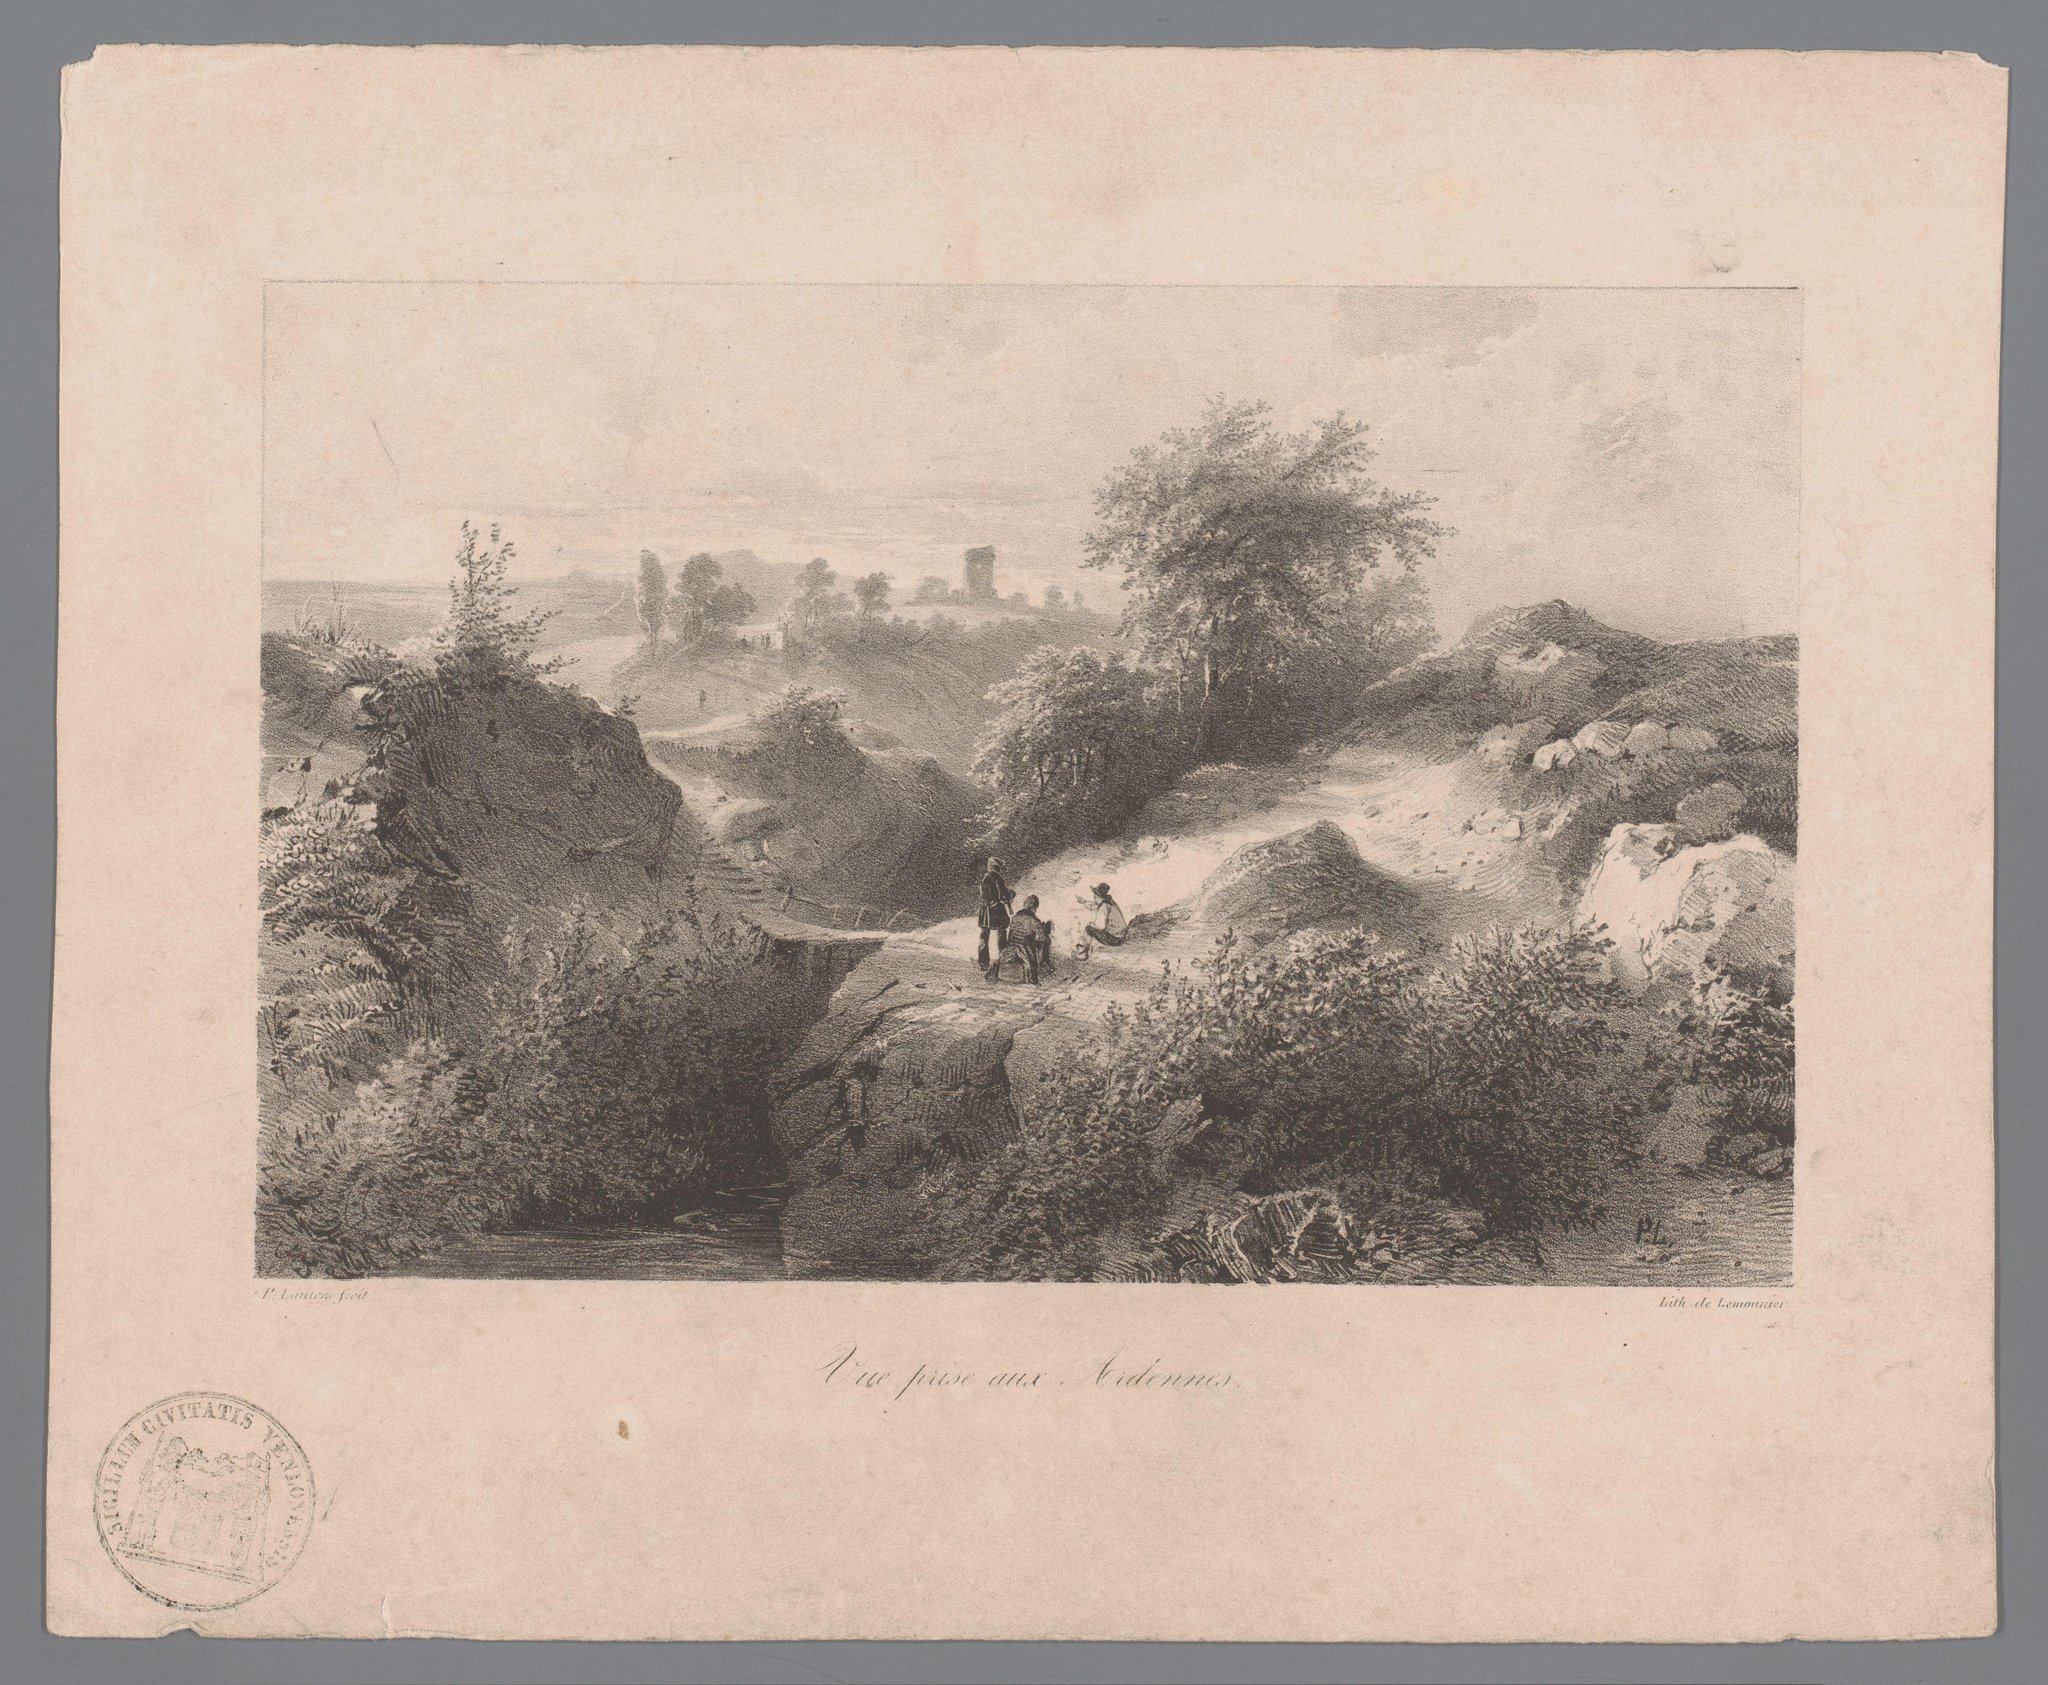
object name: print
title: Vue prise aux Ardennes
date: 1823-1841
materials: paper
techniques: lithograph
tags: mountains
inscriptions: collector's mark: Lugt 2228, collector's mark: ‘Sigillum Civitatis Venlonessis’